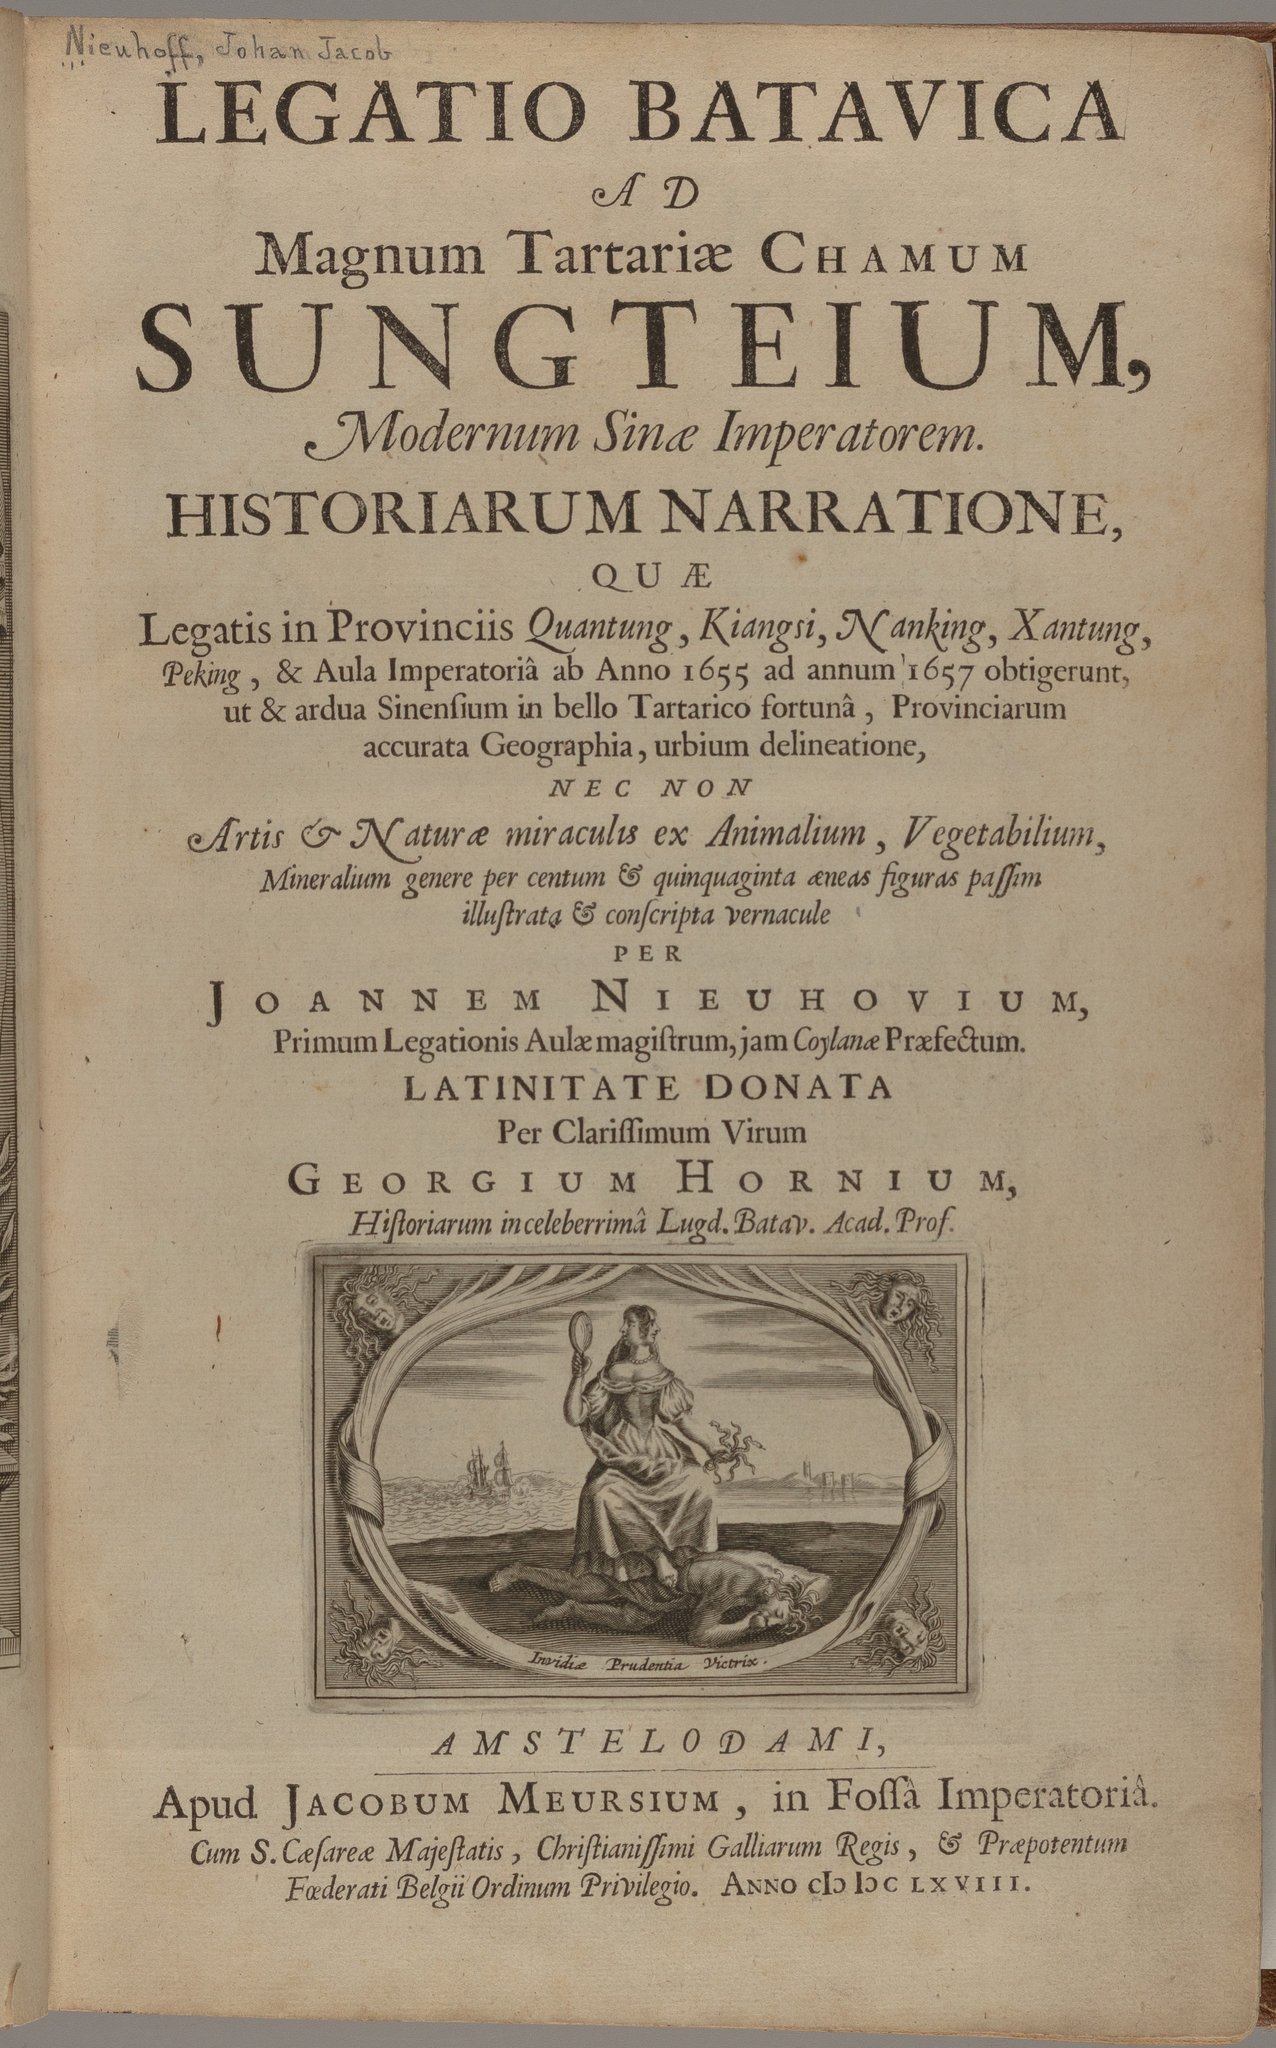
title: Legatio batavica ad magnum Tartariæ chamum Sungteium, modernum Sinæ imperatorem : historiarum narratione, quæ legatis in provinciis Quantung, Kiangsi, Nanking, Xantung, Peking, & aula imperatoriâ ab anno 1665 ad annum 1657 obtigerunt, ut & ardua Sinensium in bello tartarico fortunâ, provinciarum accurata geographia, urbium delineatione, nec non artis & naturæ miraculis ex animalium, vegetabilium, mineralium genere per centum & quinquaginta æneas figuras passim illustrata & conscripta vernacule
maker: johannes nieuhof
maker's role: author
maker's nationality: dutch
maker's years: 1618-1672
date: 1668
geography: netherlands